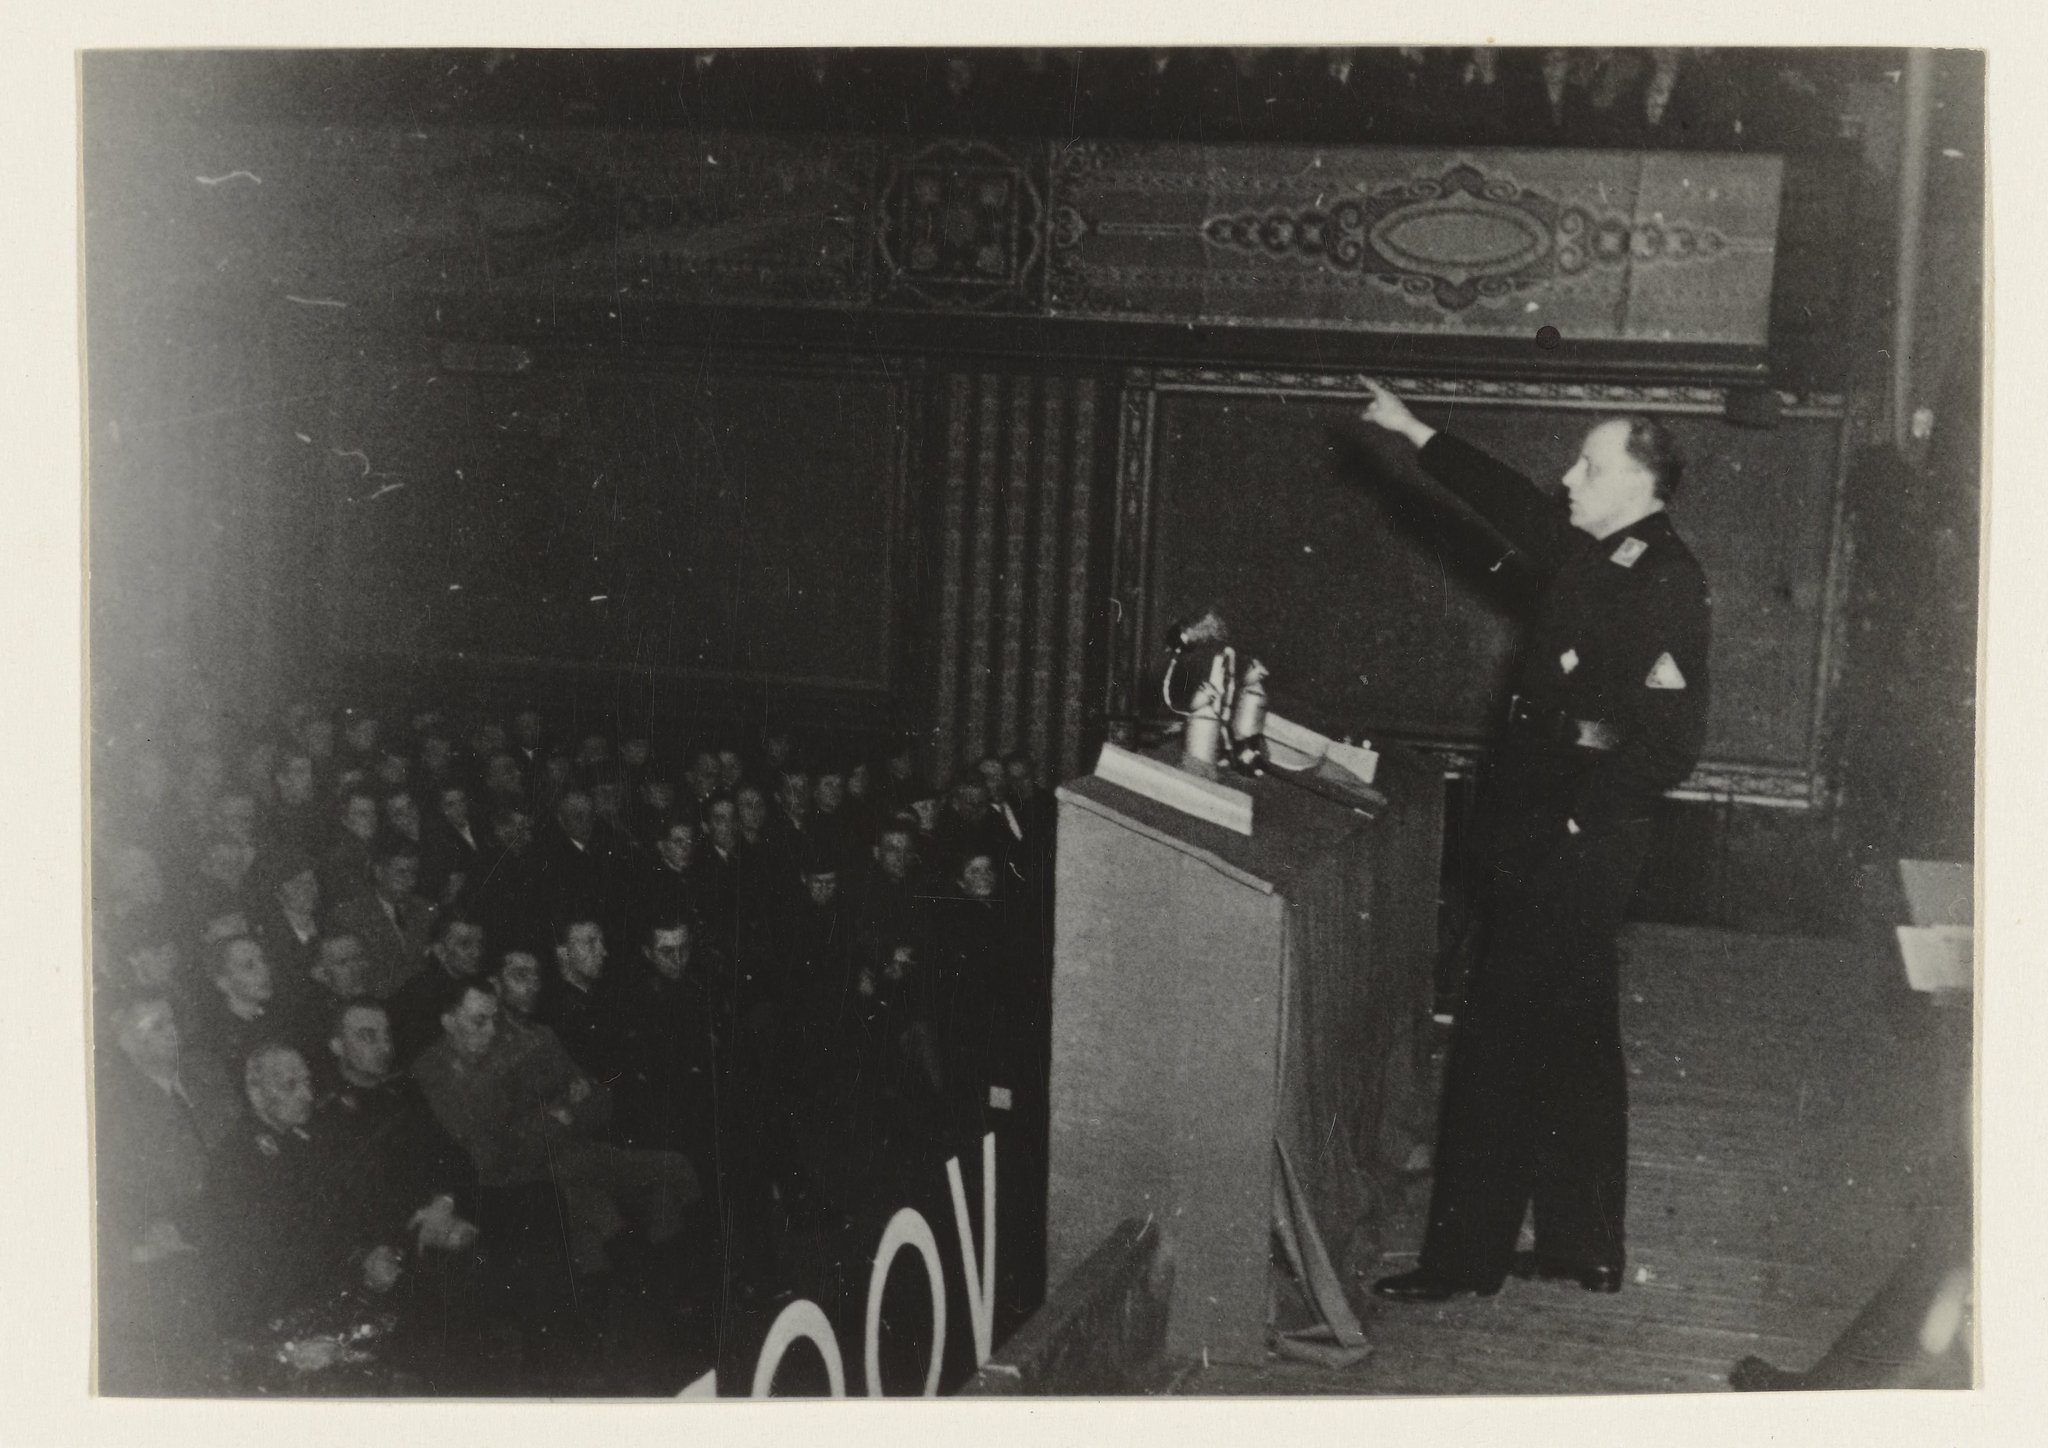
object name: photograph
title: Propagandaleider Ernst Voorhoeve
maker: Anonymous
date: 1941-1942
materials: photographic support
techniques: gelatin silver print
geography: utrecht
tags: rotterdam, political meeting, propaganda meeting, utrecht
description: Propagandaleider Ernst Voorhoeve houdt, staand achter een spreekgestoelte, een rede in een volle zaal. Hij draagt het zwarte uniform van de NSB, op zijn linkermouw is het embleem van de NSB te zien. In 1942 werd hij door Mussert benoemd tot propagandaleider van de Hoofdafdeling Pers en Propaganda. In het voorjaar van 1942 bevindt hij zich in Duitsland met het Vrijwilligerslegioen Nederland en vanaf 1943 tijdelijk aan het Oostfront. Max Blokzijl vervangt hem. Terug in Nederland ontslaat Mussert hem als Propagandaleider.